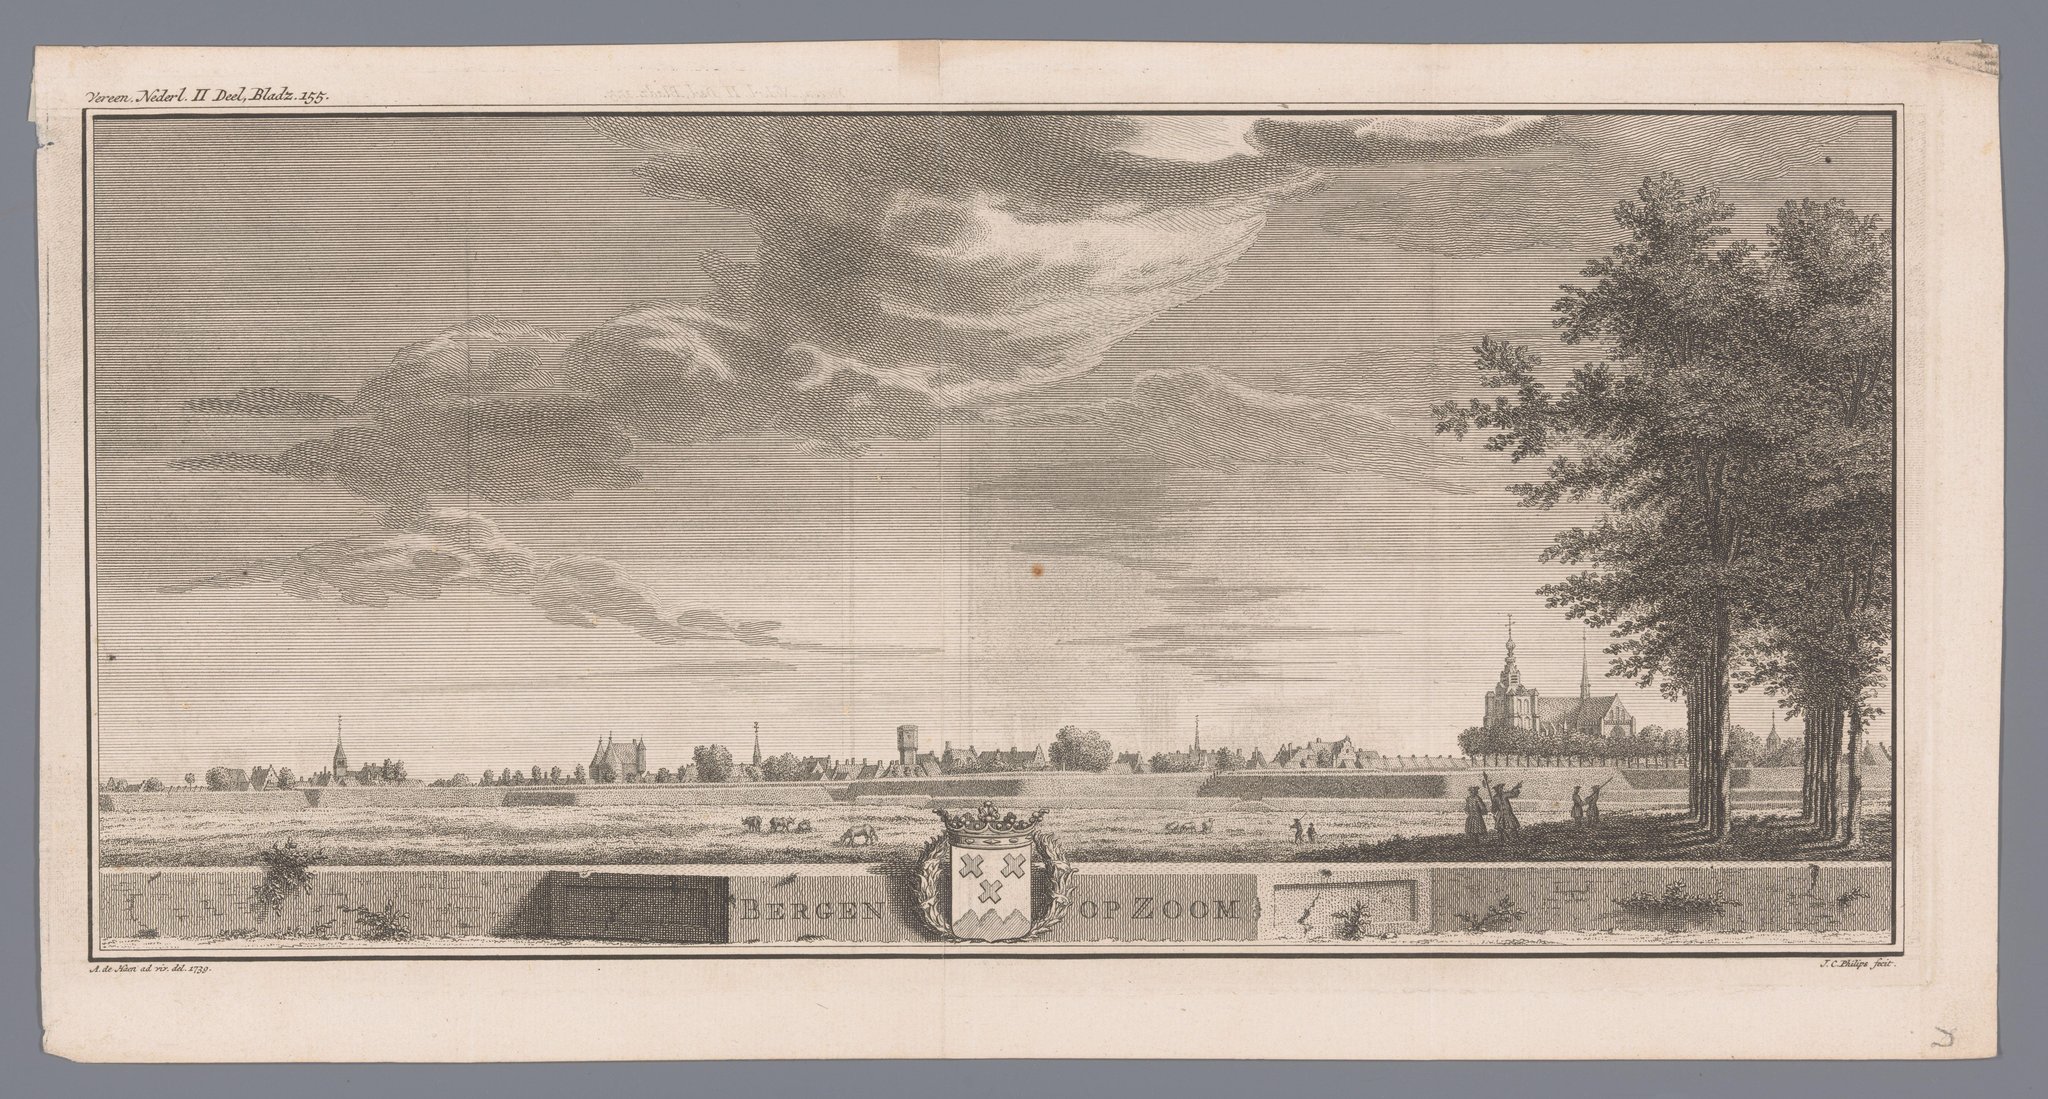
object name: print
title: Bergen op Zoom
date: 1740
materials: paper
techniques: engraving, etching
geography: amsterdam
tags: prospect of village, silhouette of village, bergen op zoom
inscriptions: collector's mark: Lugt 2233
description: Prent uit: Wagenaar, Jan. Tegenwoordige staat der Vereenigde Nederlanden. Tweede deel. Vervattende eene beschryving der Generaliteits Landen. Amsterdam: Isaak Tirion, 1740.